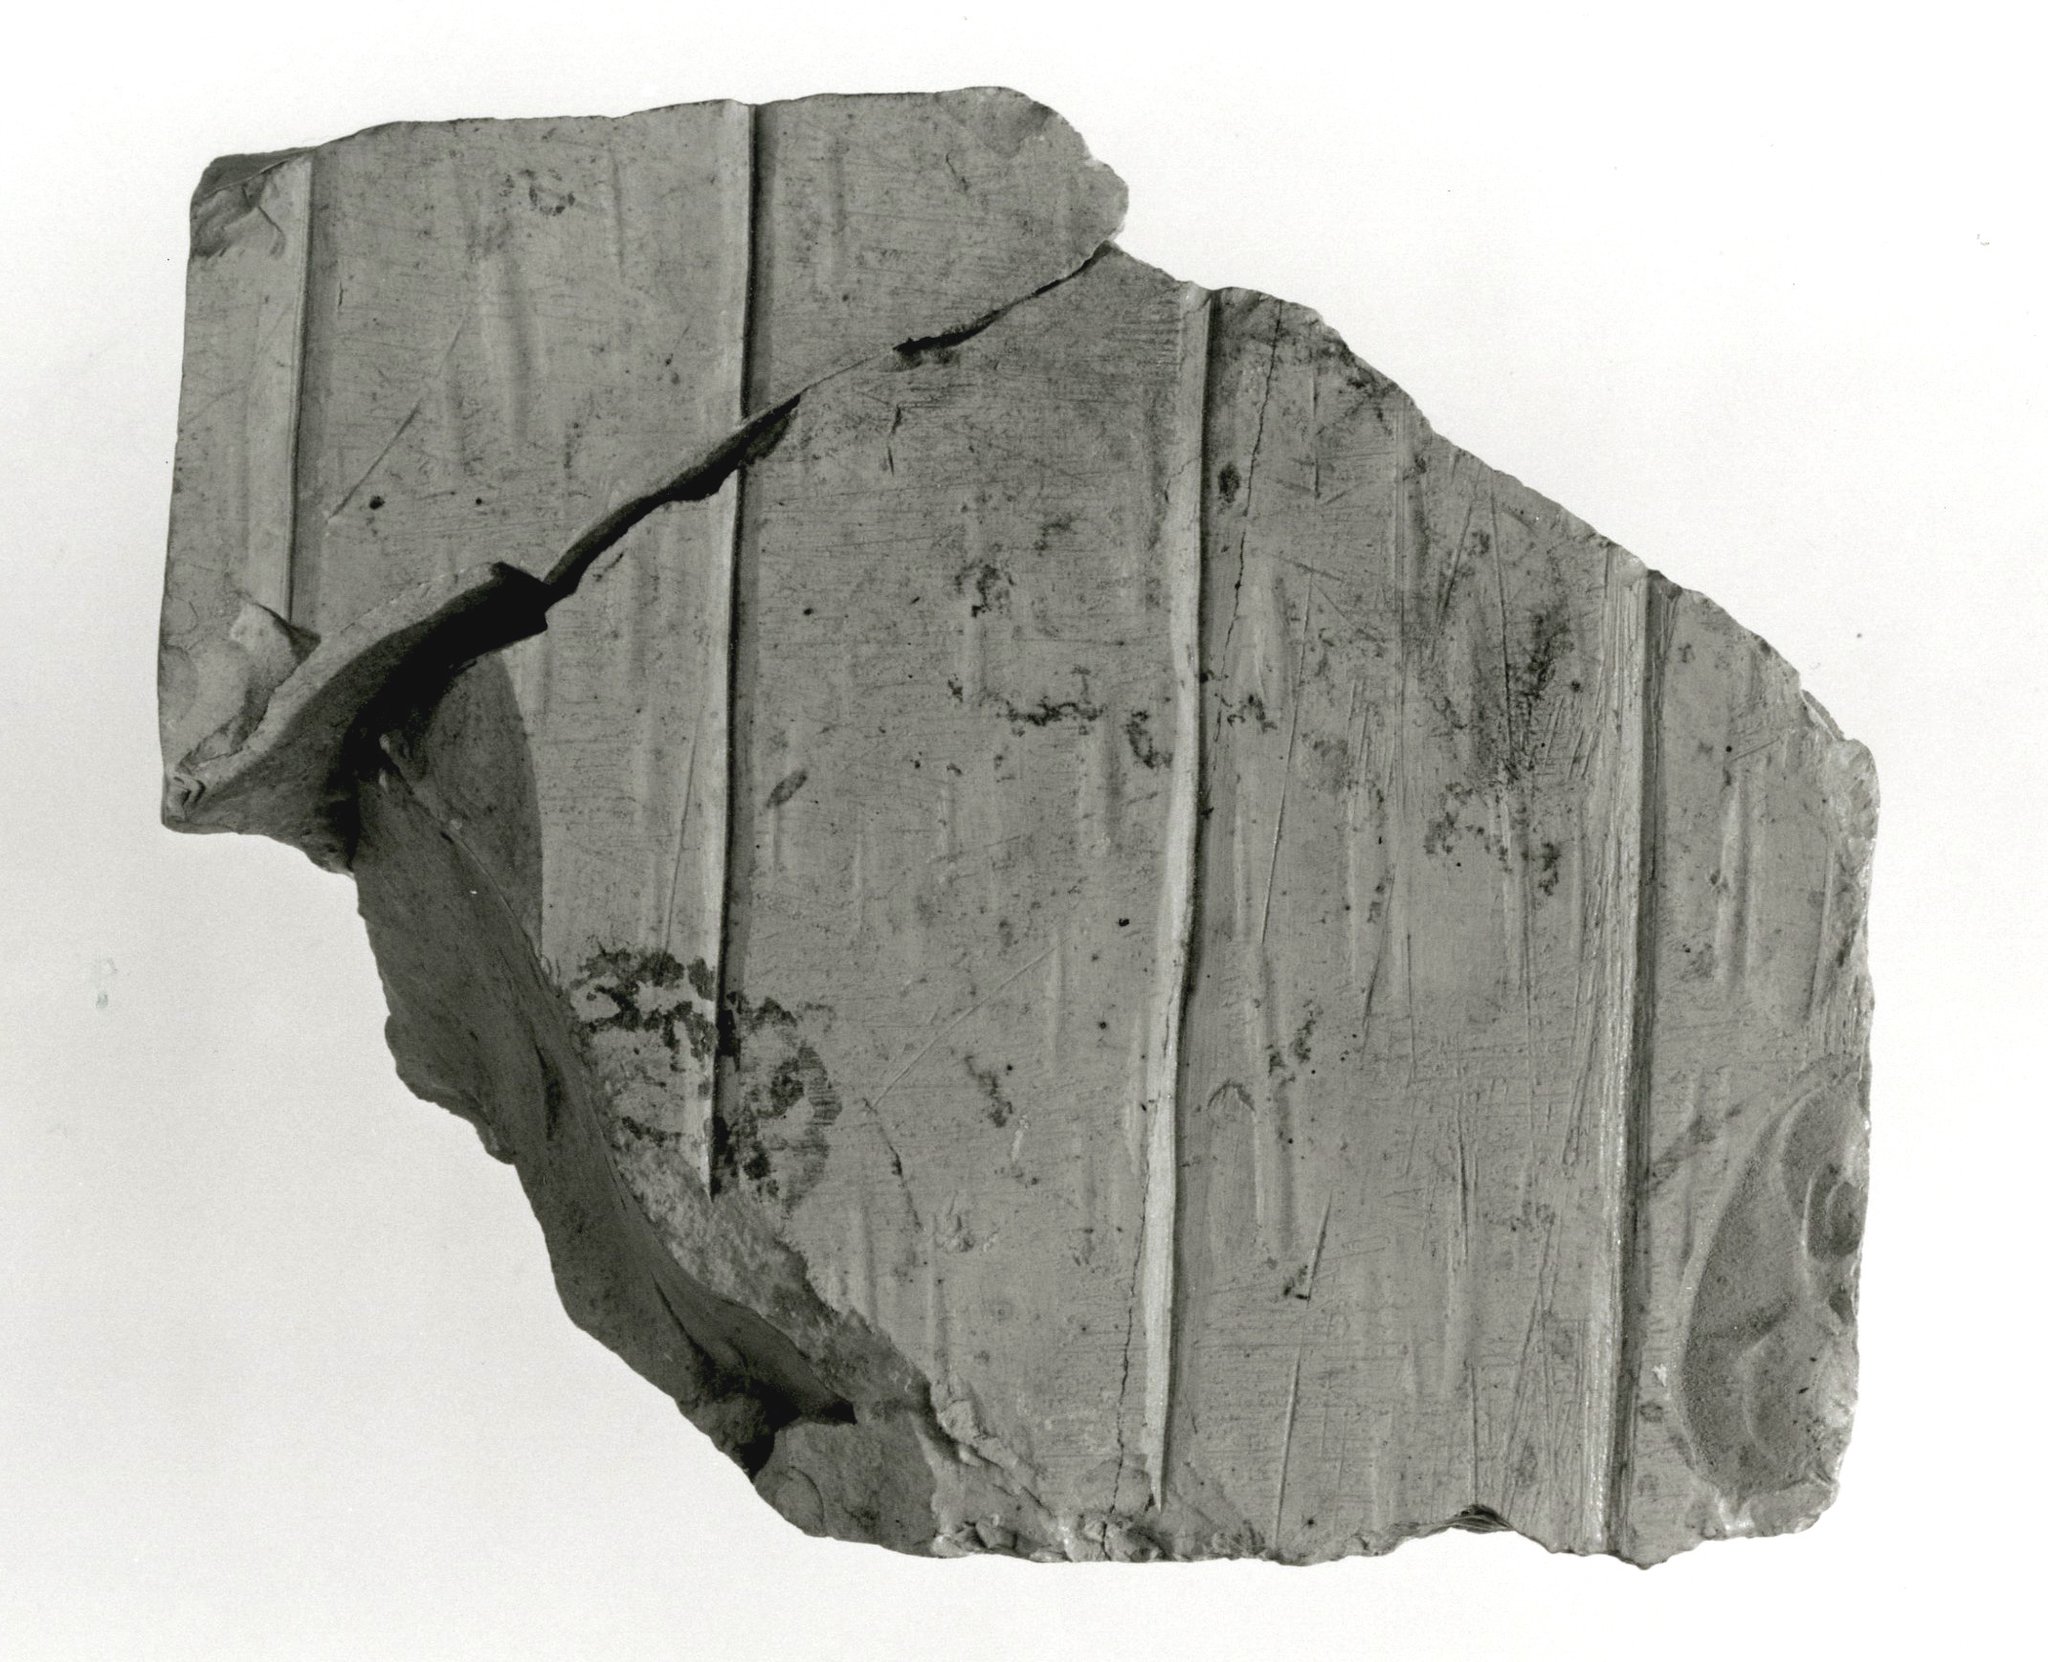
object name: relief, tomb of nespekashuty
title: Raised relief fragment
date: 664-610 BCE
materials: limestone, varnish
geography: egypt